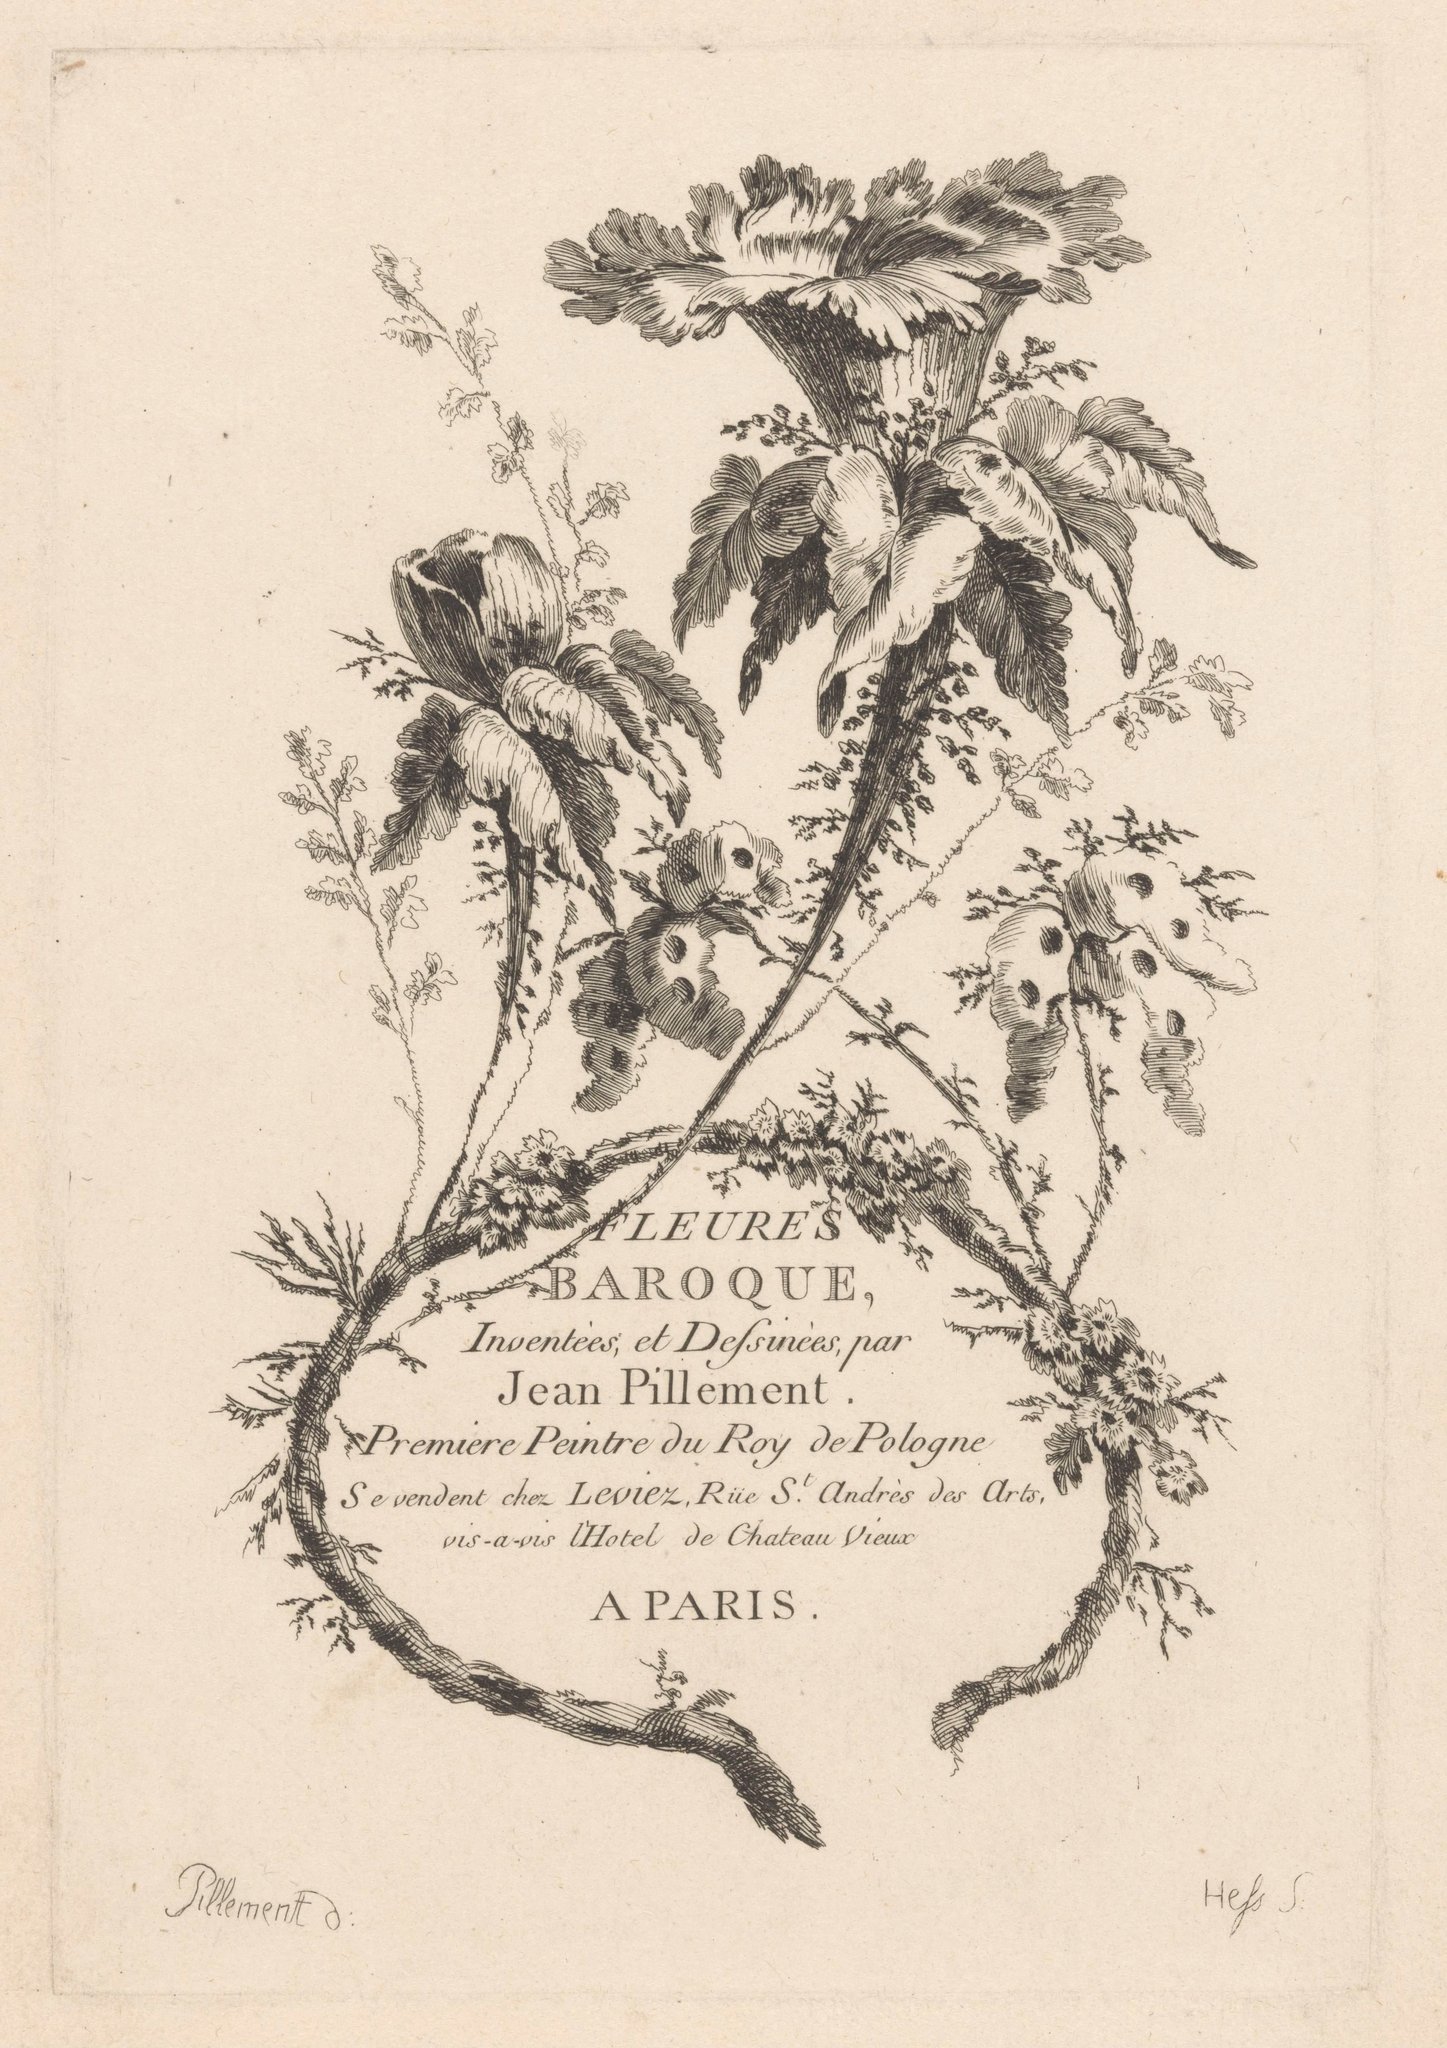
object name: ornament print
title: Trompetvormige bloemen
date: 1755-1775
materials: paper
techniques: etching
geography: paris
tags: flowers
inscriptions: collector's mark: Lugt 2228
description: Twee trompetvormige bloemen, daaronder de serietitel.